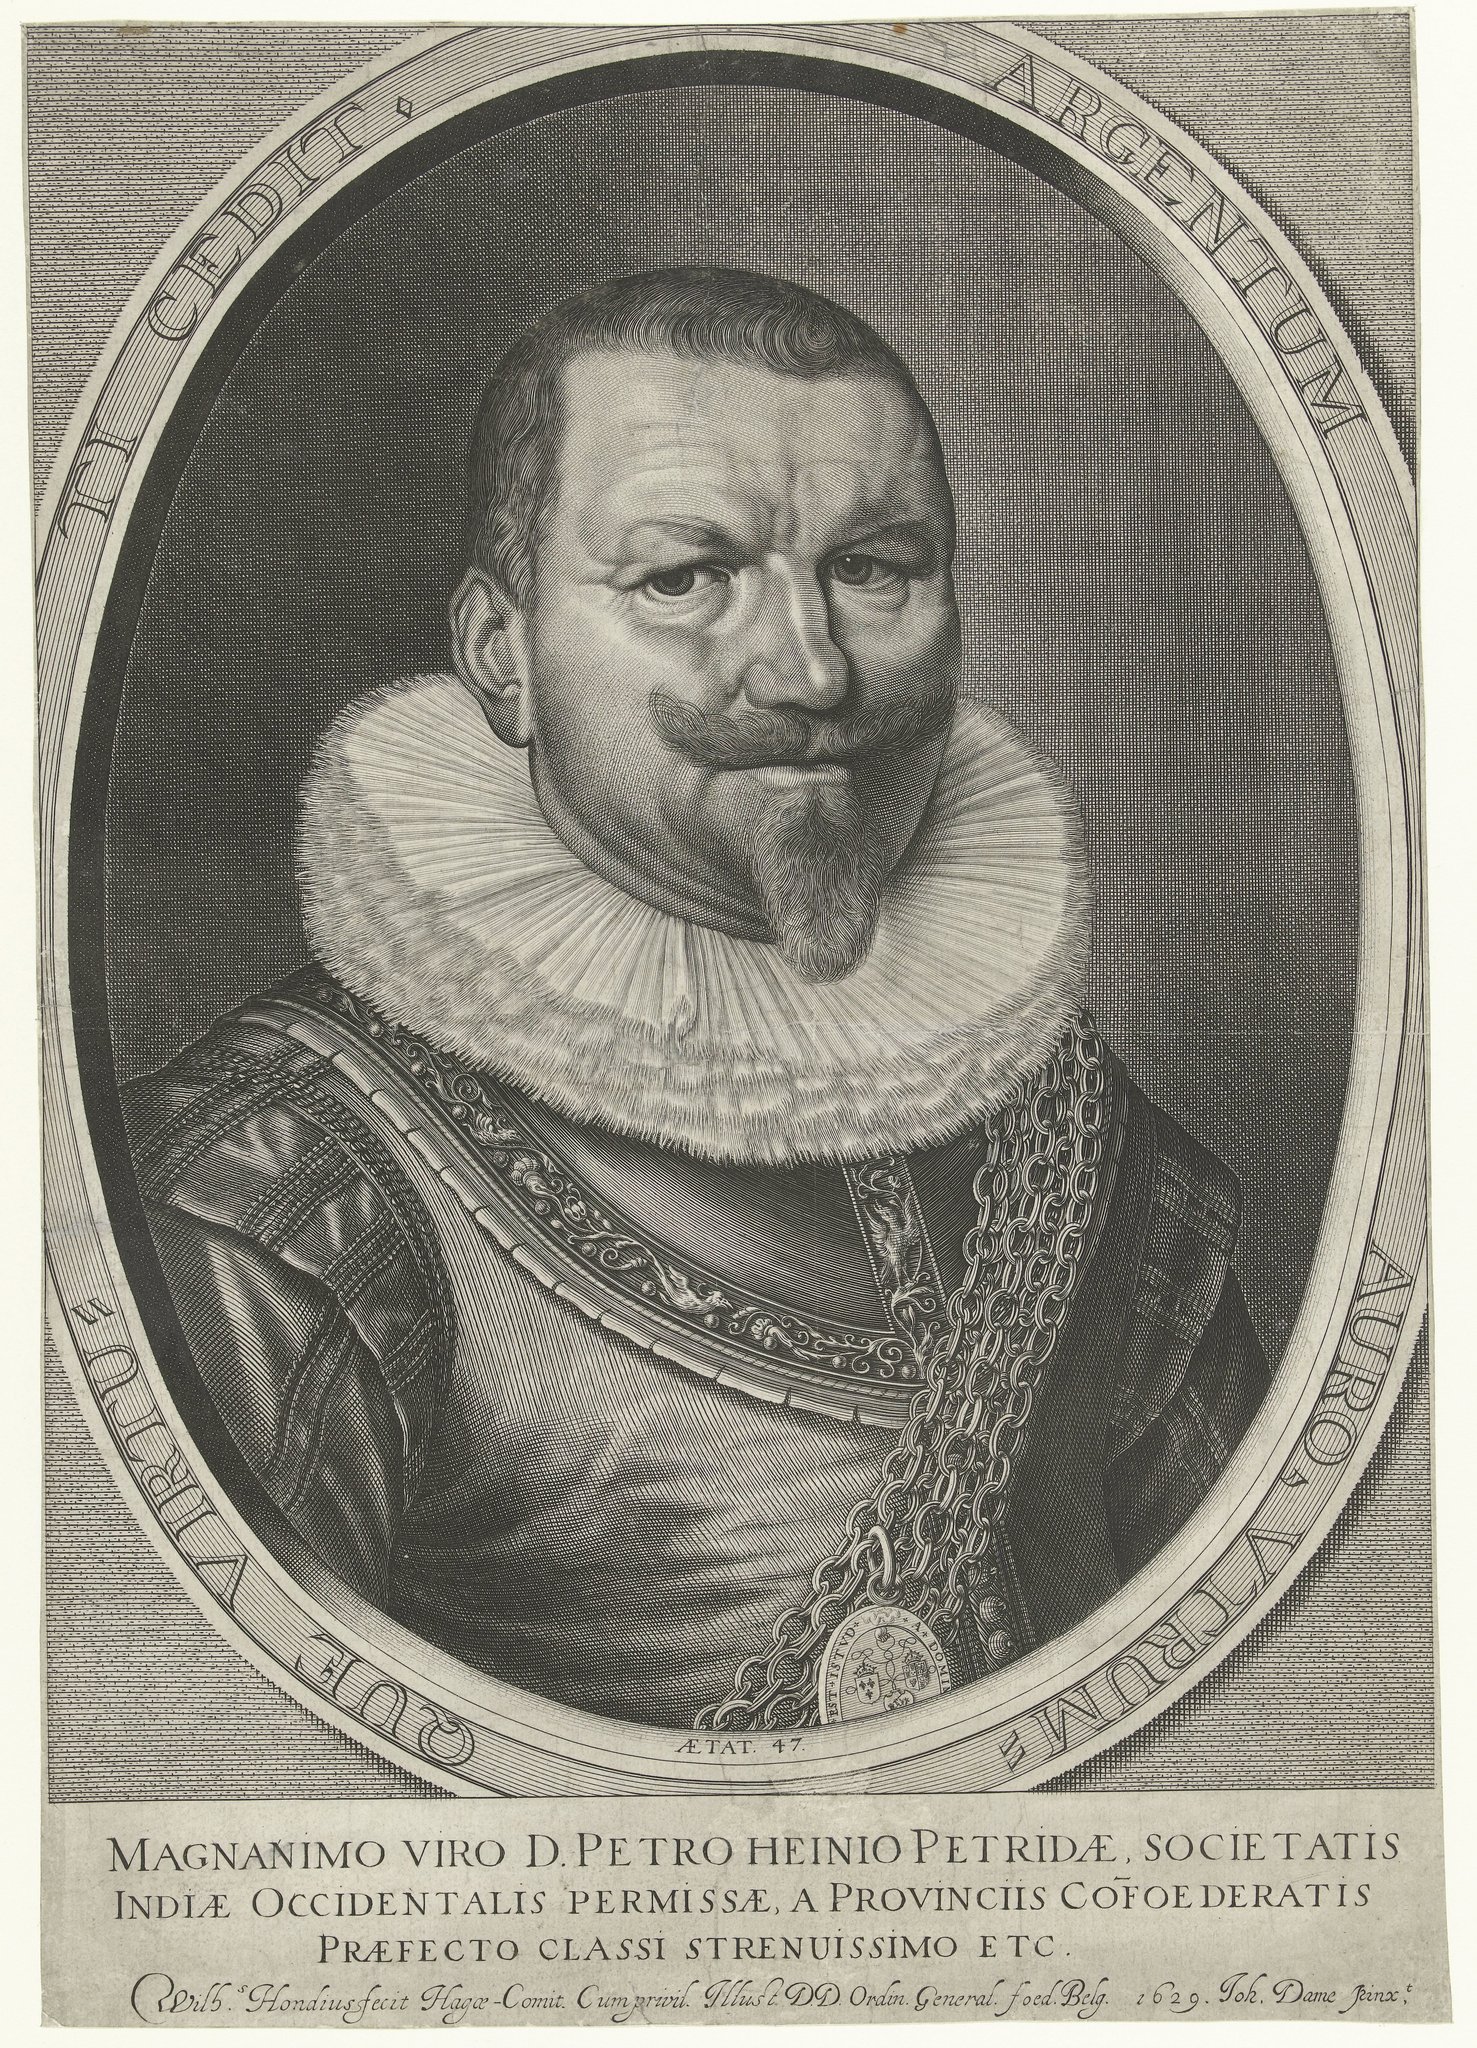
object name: print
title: Portret van Piet Hein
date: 1629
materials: paper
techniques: engraving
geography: the hague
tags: delfshaven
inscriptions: collector's mark: Lugt 2228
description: Buste naar rechts van Piet Hein op 47-jarige leeftijd in een ovale omlijsting met randschrift in het Latijn. Onder het portret drie regels in het Latijn.